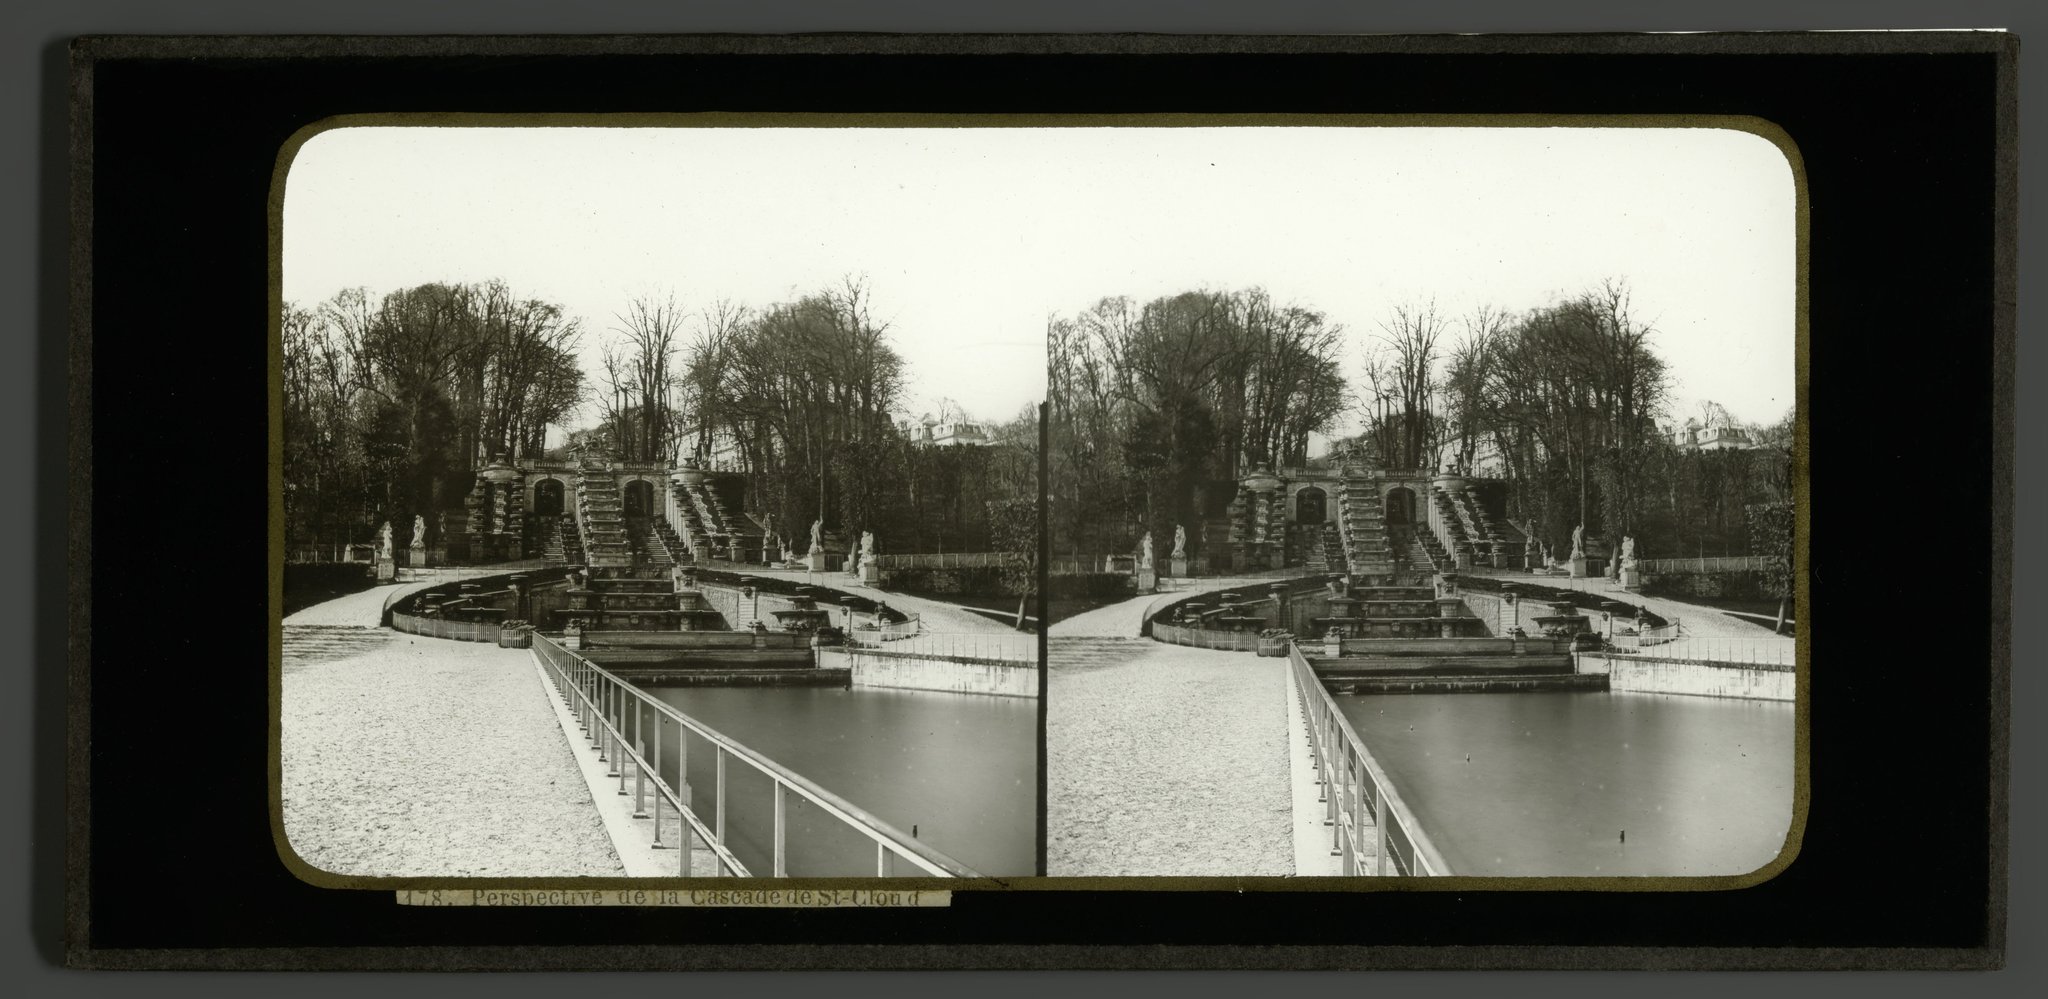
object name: photograph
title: Perspective de la Cascade de St-Cloud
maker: Anonymous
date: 1860-1890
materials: glass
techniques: slide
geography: paris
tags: waterfall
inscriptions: inscription: ‘Péristyle Valois, Palais-Royal,/ a dossè au Jardin, près la galerie d'orléans./ ALEXIS FAY/ Opticien; Grande Spécialité de Stéréoscopes et Microscopes.’, number: ‘178.’